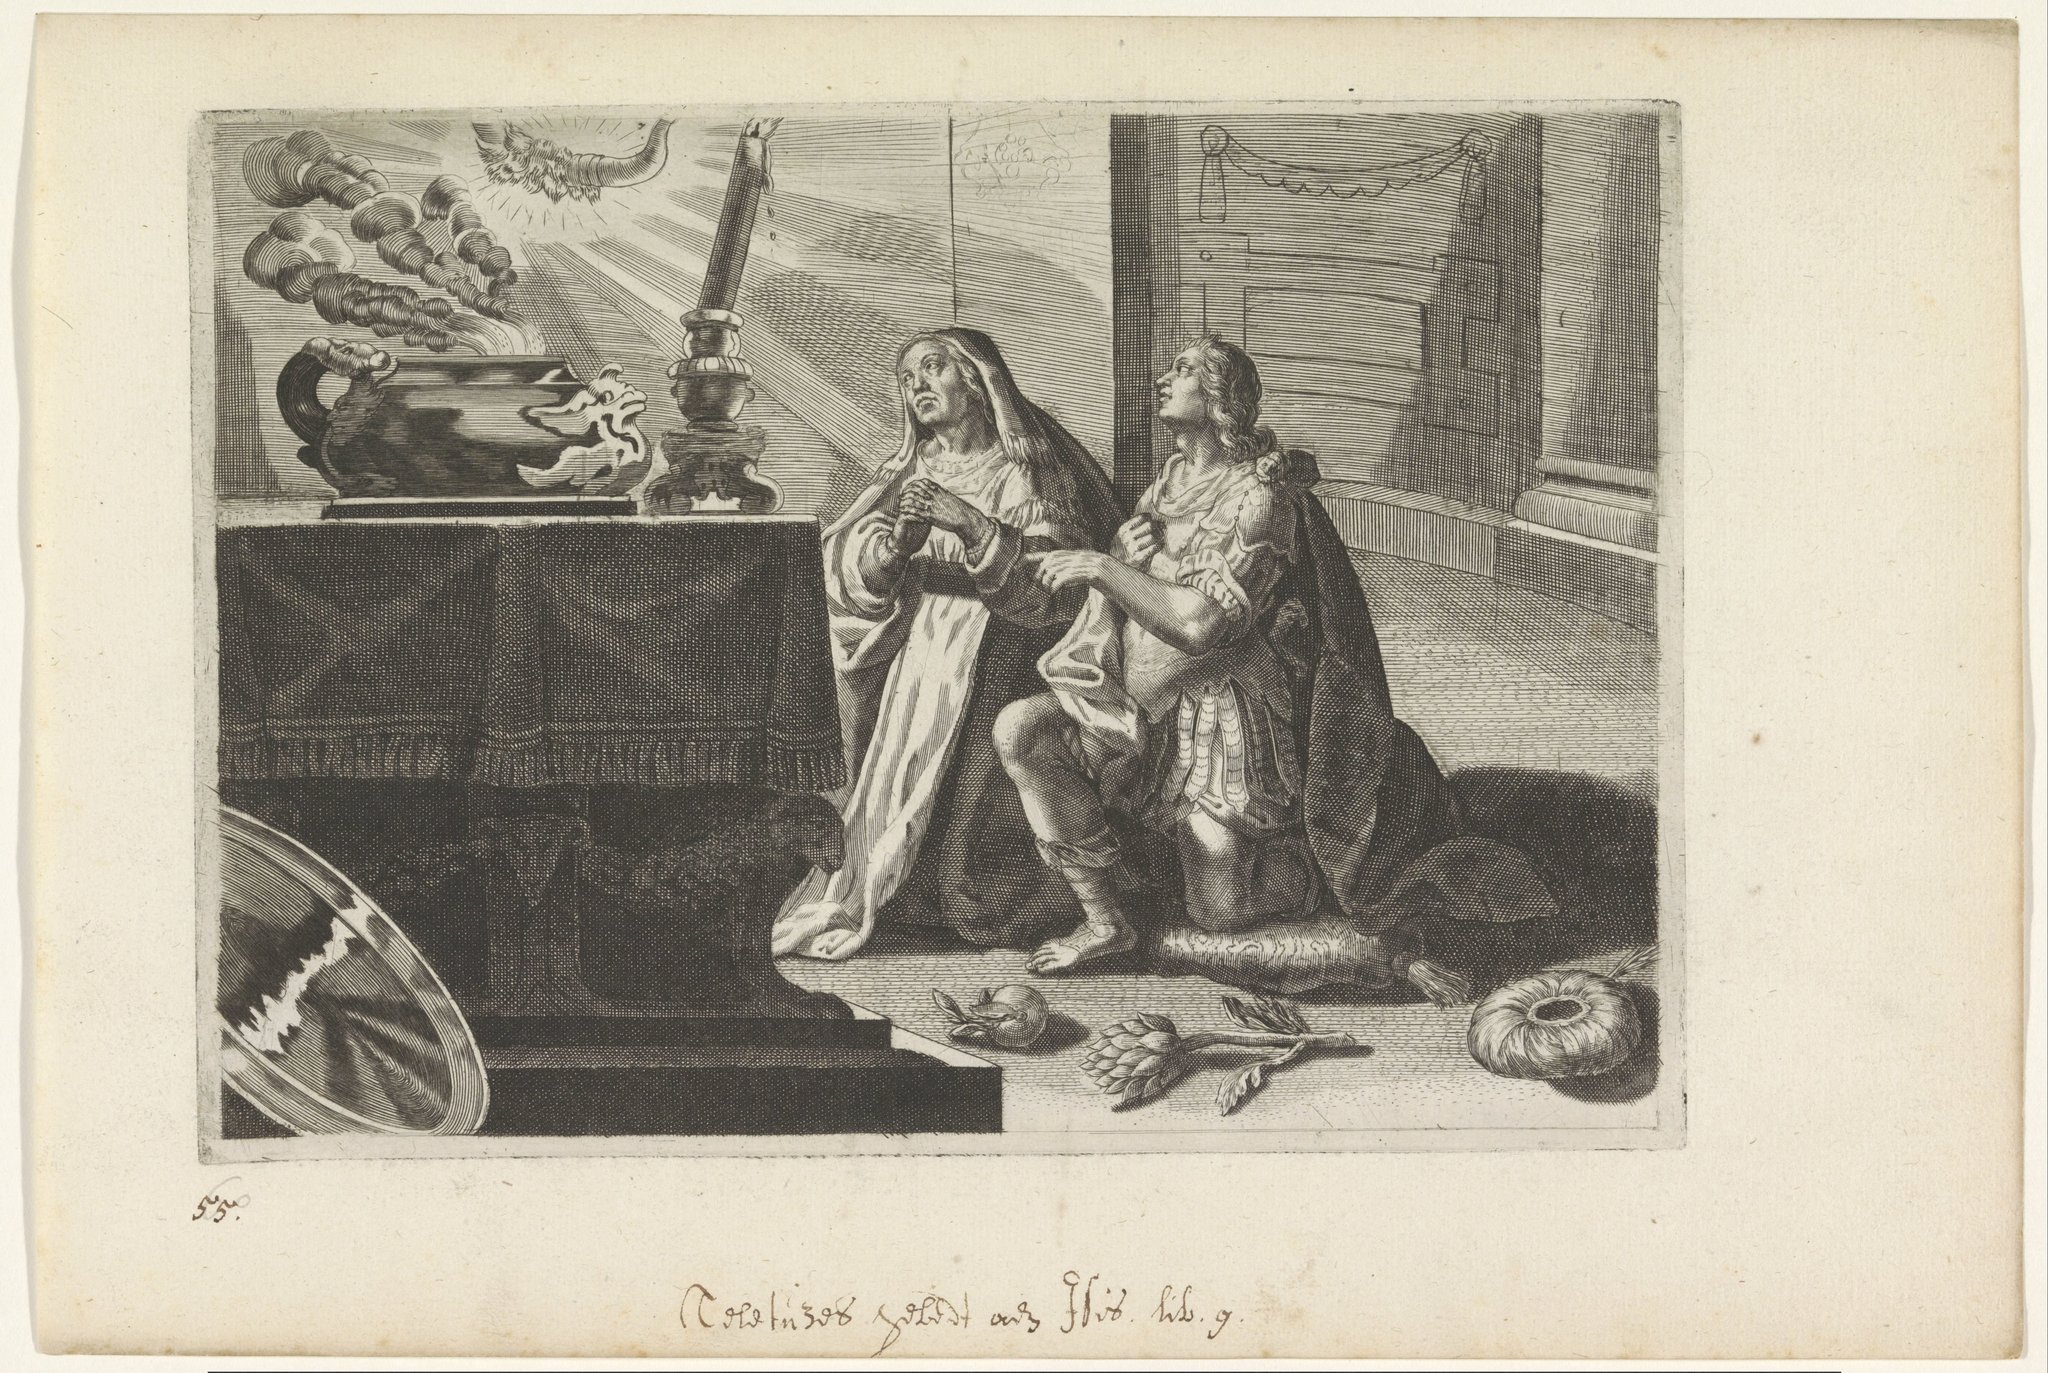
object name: print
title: Telethusa en Iphis bidden tot Isis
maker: crispijn van de passe (ii)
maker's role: draughtsman, print maker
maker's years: 1594-1670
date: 1636-1670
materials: paper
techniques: engraving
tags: iphis and telethusa implore the assistance of isis, transgender, transsexual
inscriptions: number: ‘55’, annotation: ‘Teletuzes gebed aen Isis. lib. 9.’, collector's mark: ‘Hinloopen’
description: Deze incomplete serie, bestaande uit 77 van de in totaal 85 prenten met scènes uit Ovidius' Metamorfosen, werd in 1709 samen met Ovidius-illustraties van Tempesta, Goltzius en Le Pautre in één album, Schijnvoet nummer 43, ingebonden. In de negentiende eeuw werd deze band weer uit elkaar gehaald.